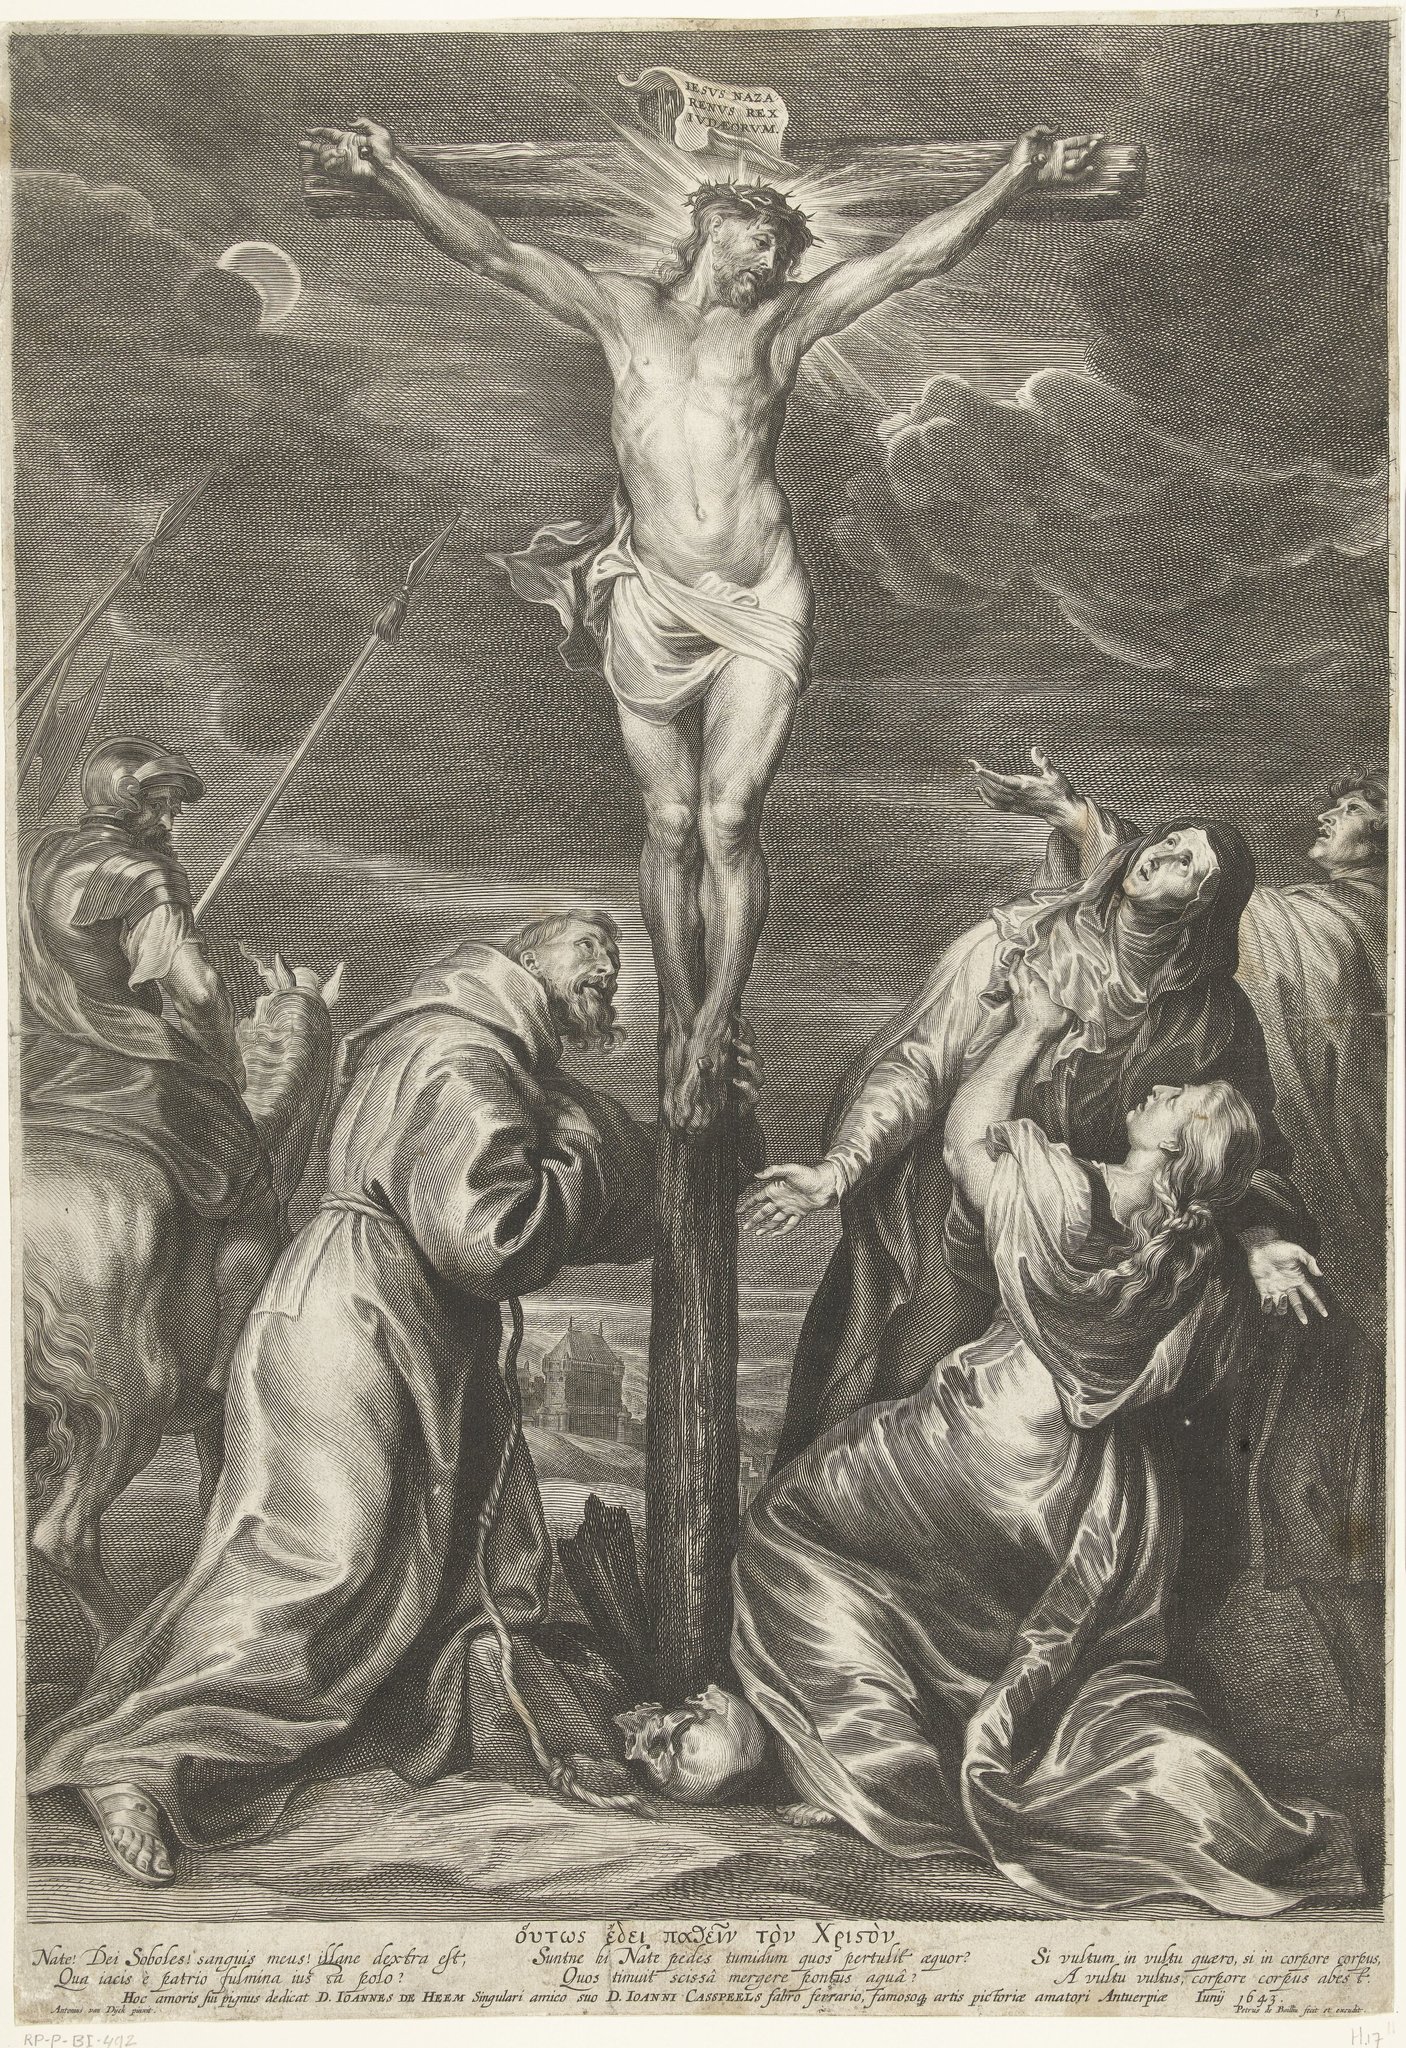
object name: print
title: Christus aan het kruis met Maria en Maria Magdalena en Johannes de Evangelist en Franciscus van Assisi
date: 1623-1660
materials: paper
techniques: engraving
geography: antwerp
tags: crucified christ with mary, john, and mary magdalene, crucified christ with other persons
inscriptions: collector's mark: Lugt 240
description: Prent naar schilderij van Anthony van Dijk. De prent is opgedragen aan Ioanni Casspeels, een kunstschilder uit Antwerpen, juni 1643. Het is onduidelijk onder welke naam deze kunstenaar bij ons bekend is.